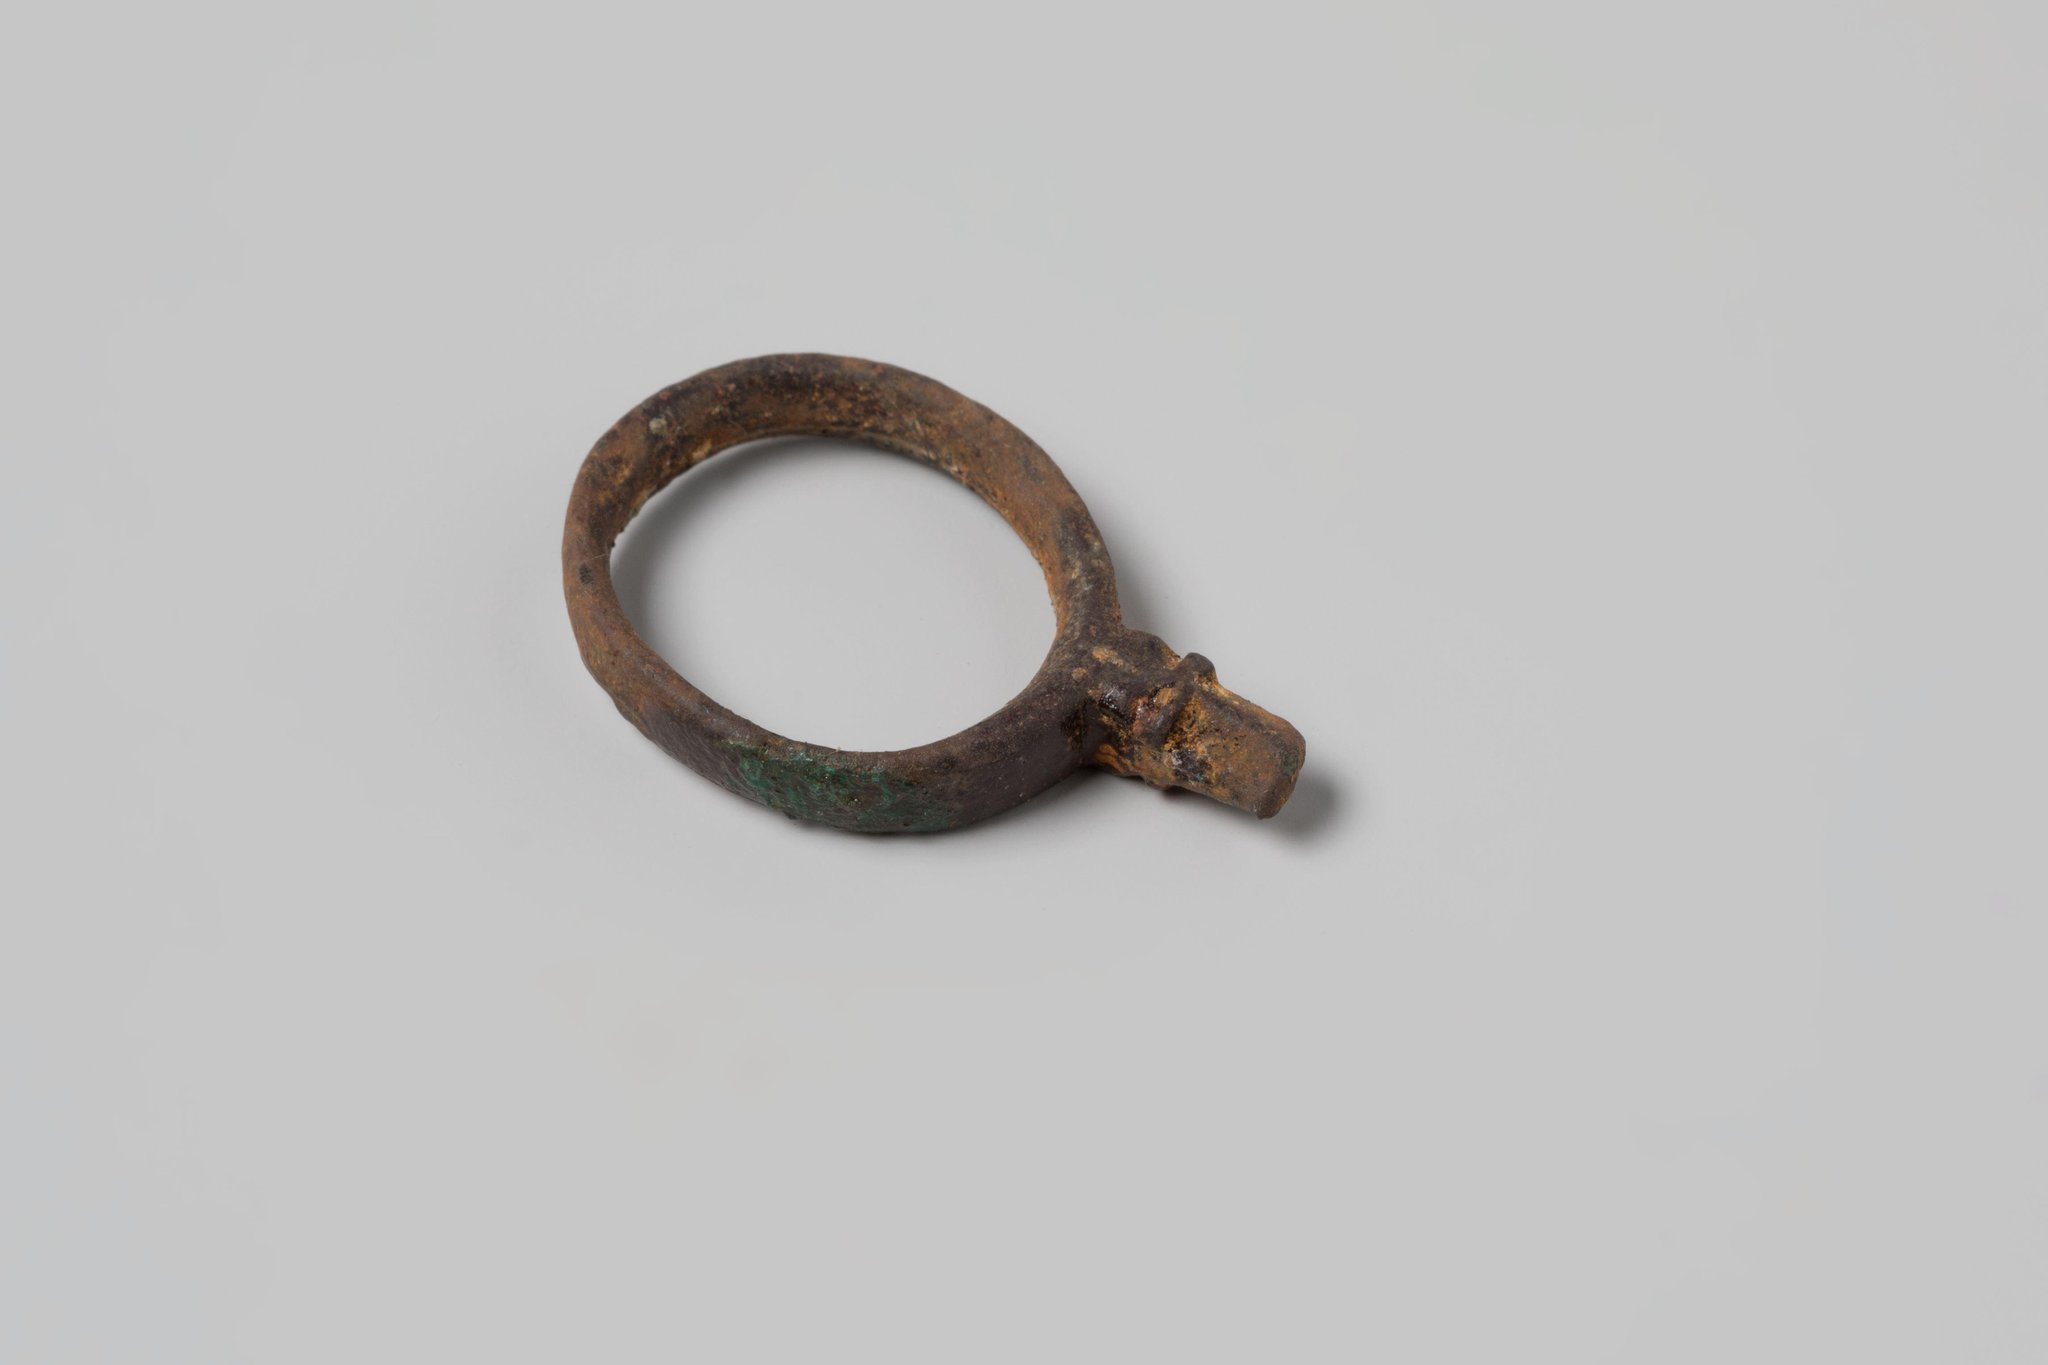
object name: pin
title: Speld uit het wrak van de Oost-Indiëvaarder Hollandia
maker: Anonymous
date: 1700-1743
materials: copper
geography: netherlands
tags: verenigde oostindische compagnie, hollandia (schip), annet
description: Tools and instruments, sewing and sailmaking, pin; fragm, bow, id. NG 1980-27H3265.